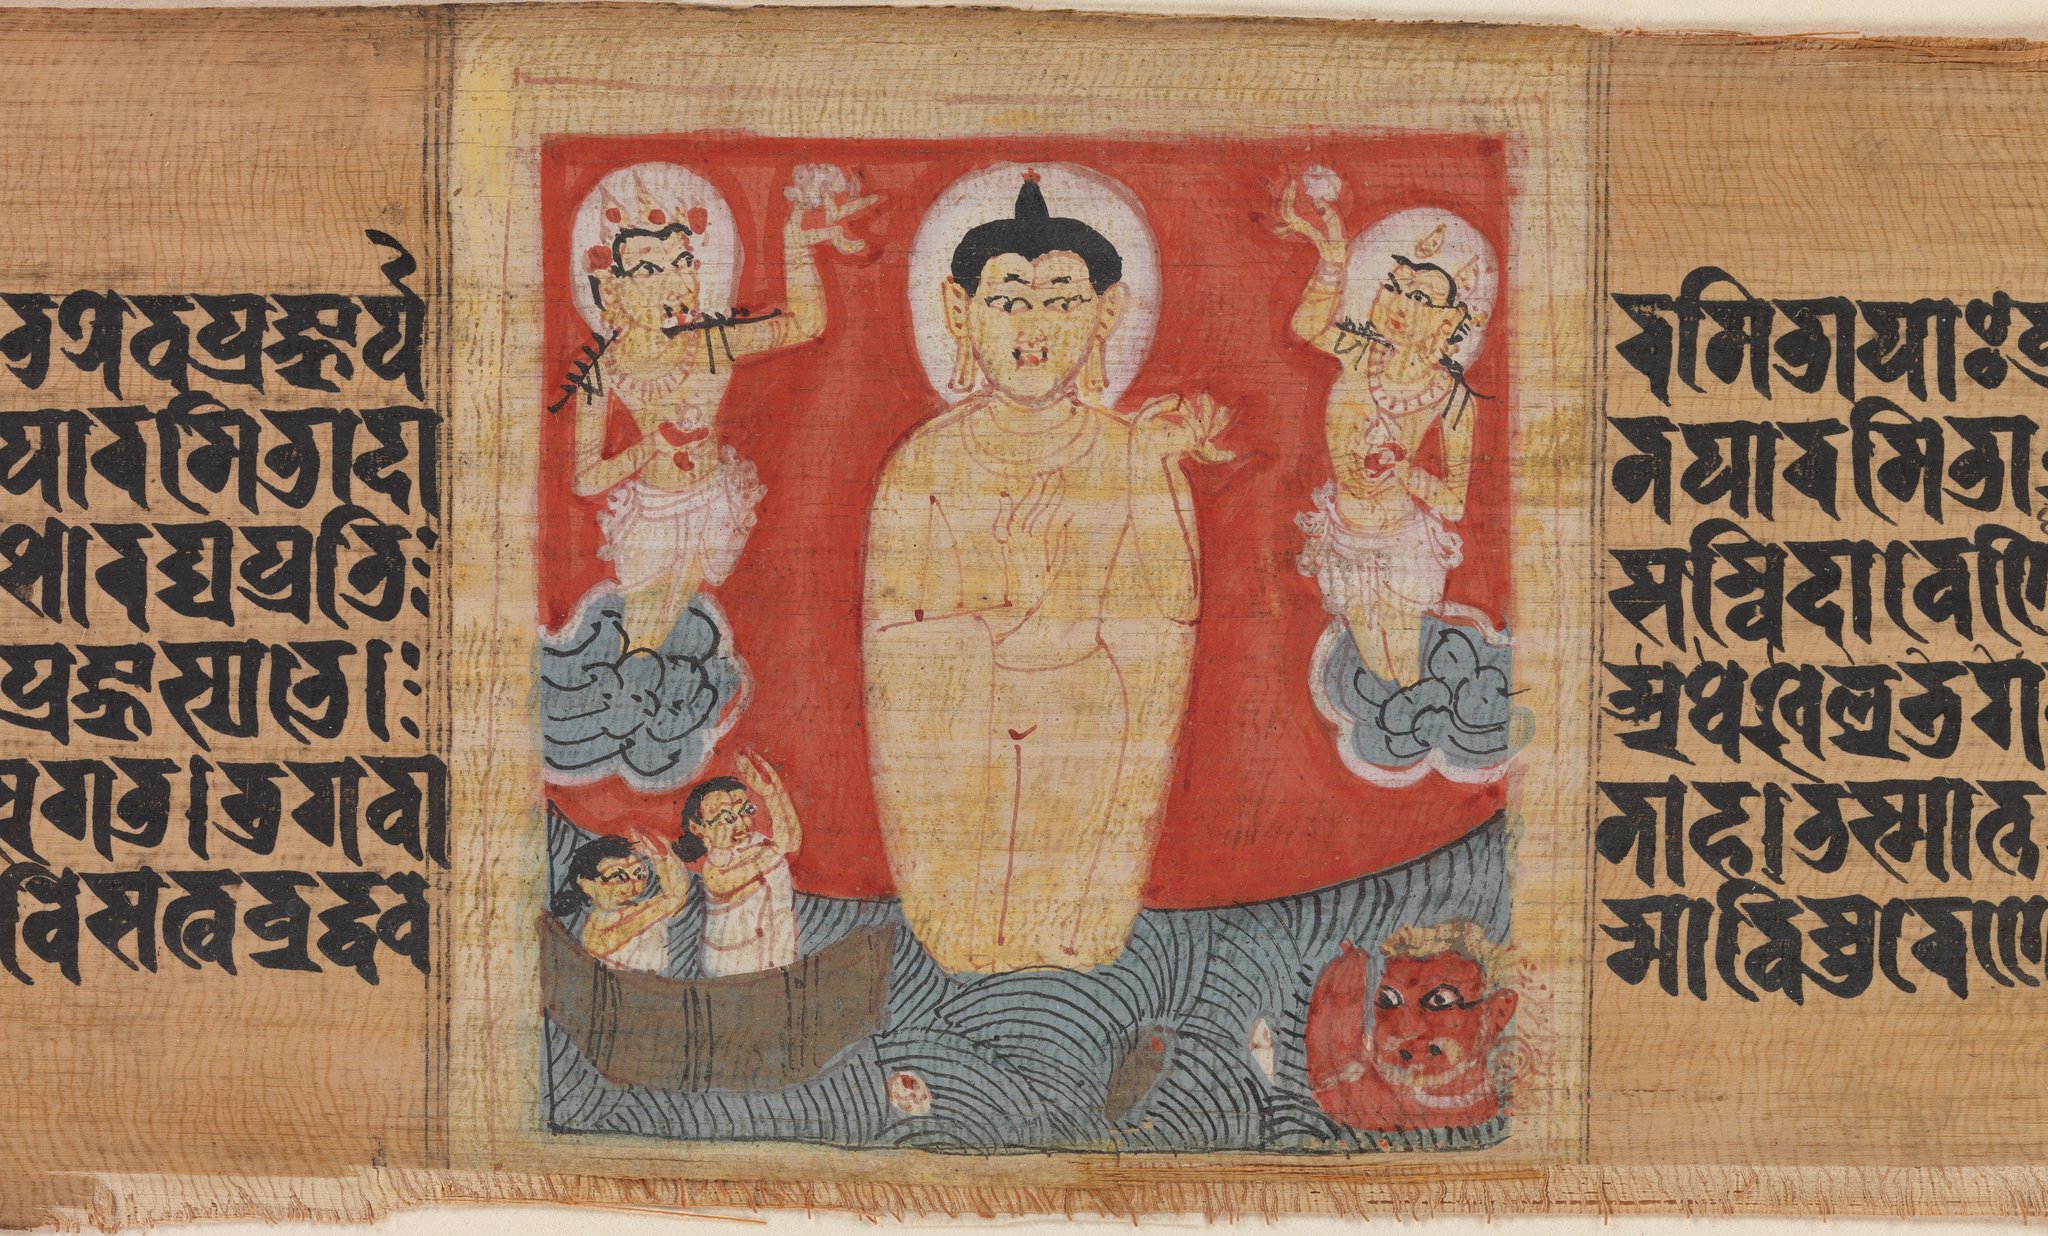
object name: folio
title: Buddha Giving Safety (Abhayananda) to Mariners, Leaf from a Dispersed Pancavimsatisahasrika Prajnapramita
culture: indian, bengal or bangladesh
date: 1090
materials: ink, leaf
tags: buddha,deities,boats